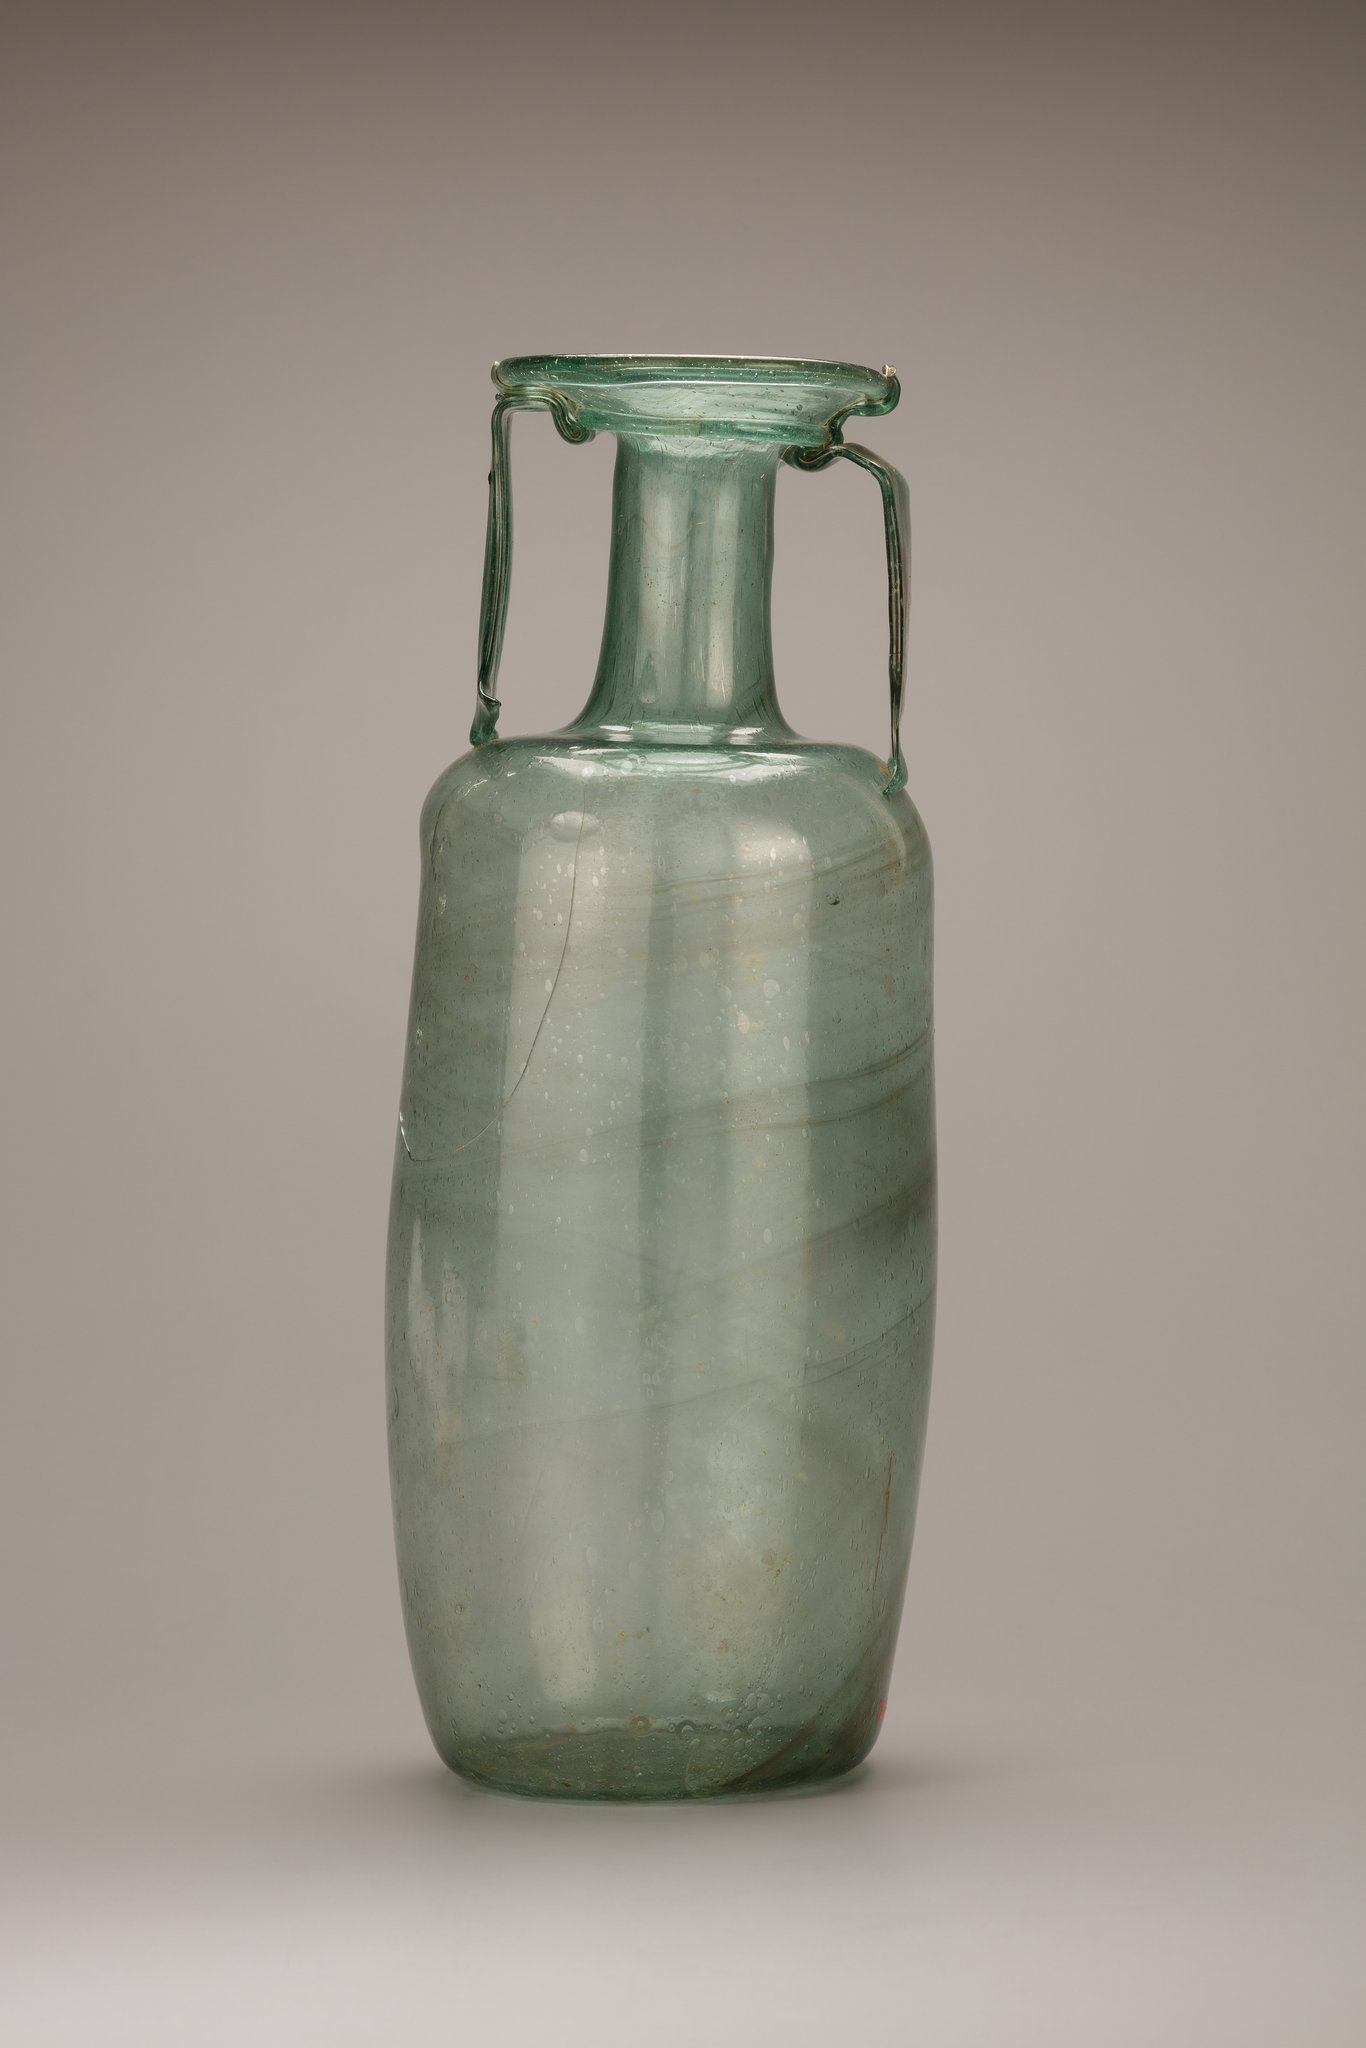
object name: bottle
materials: glass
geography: middle egypt